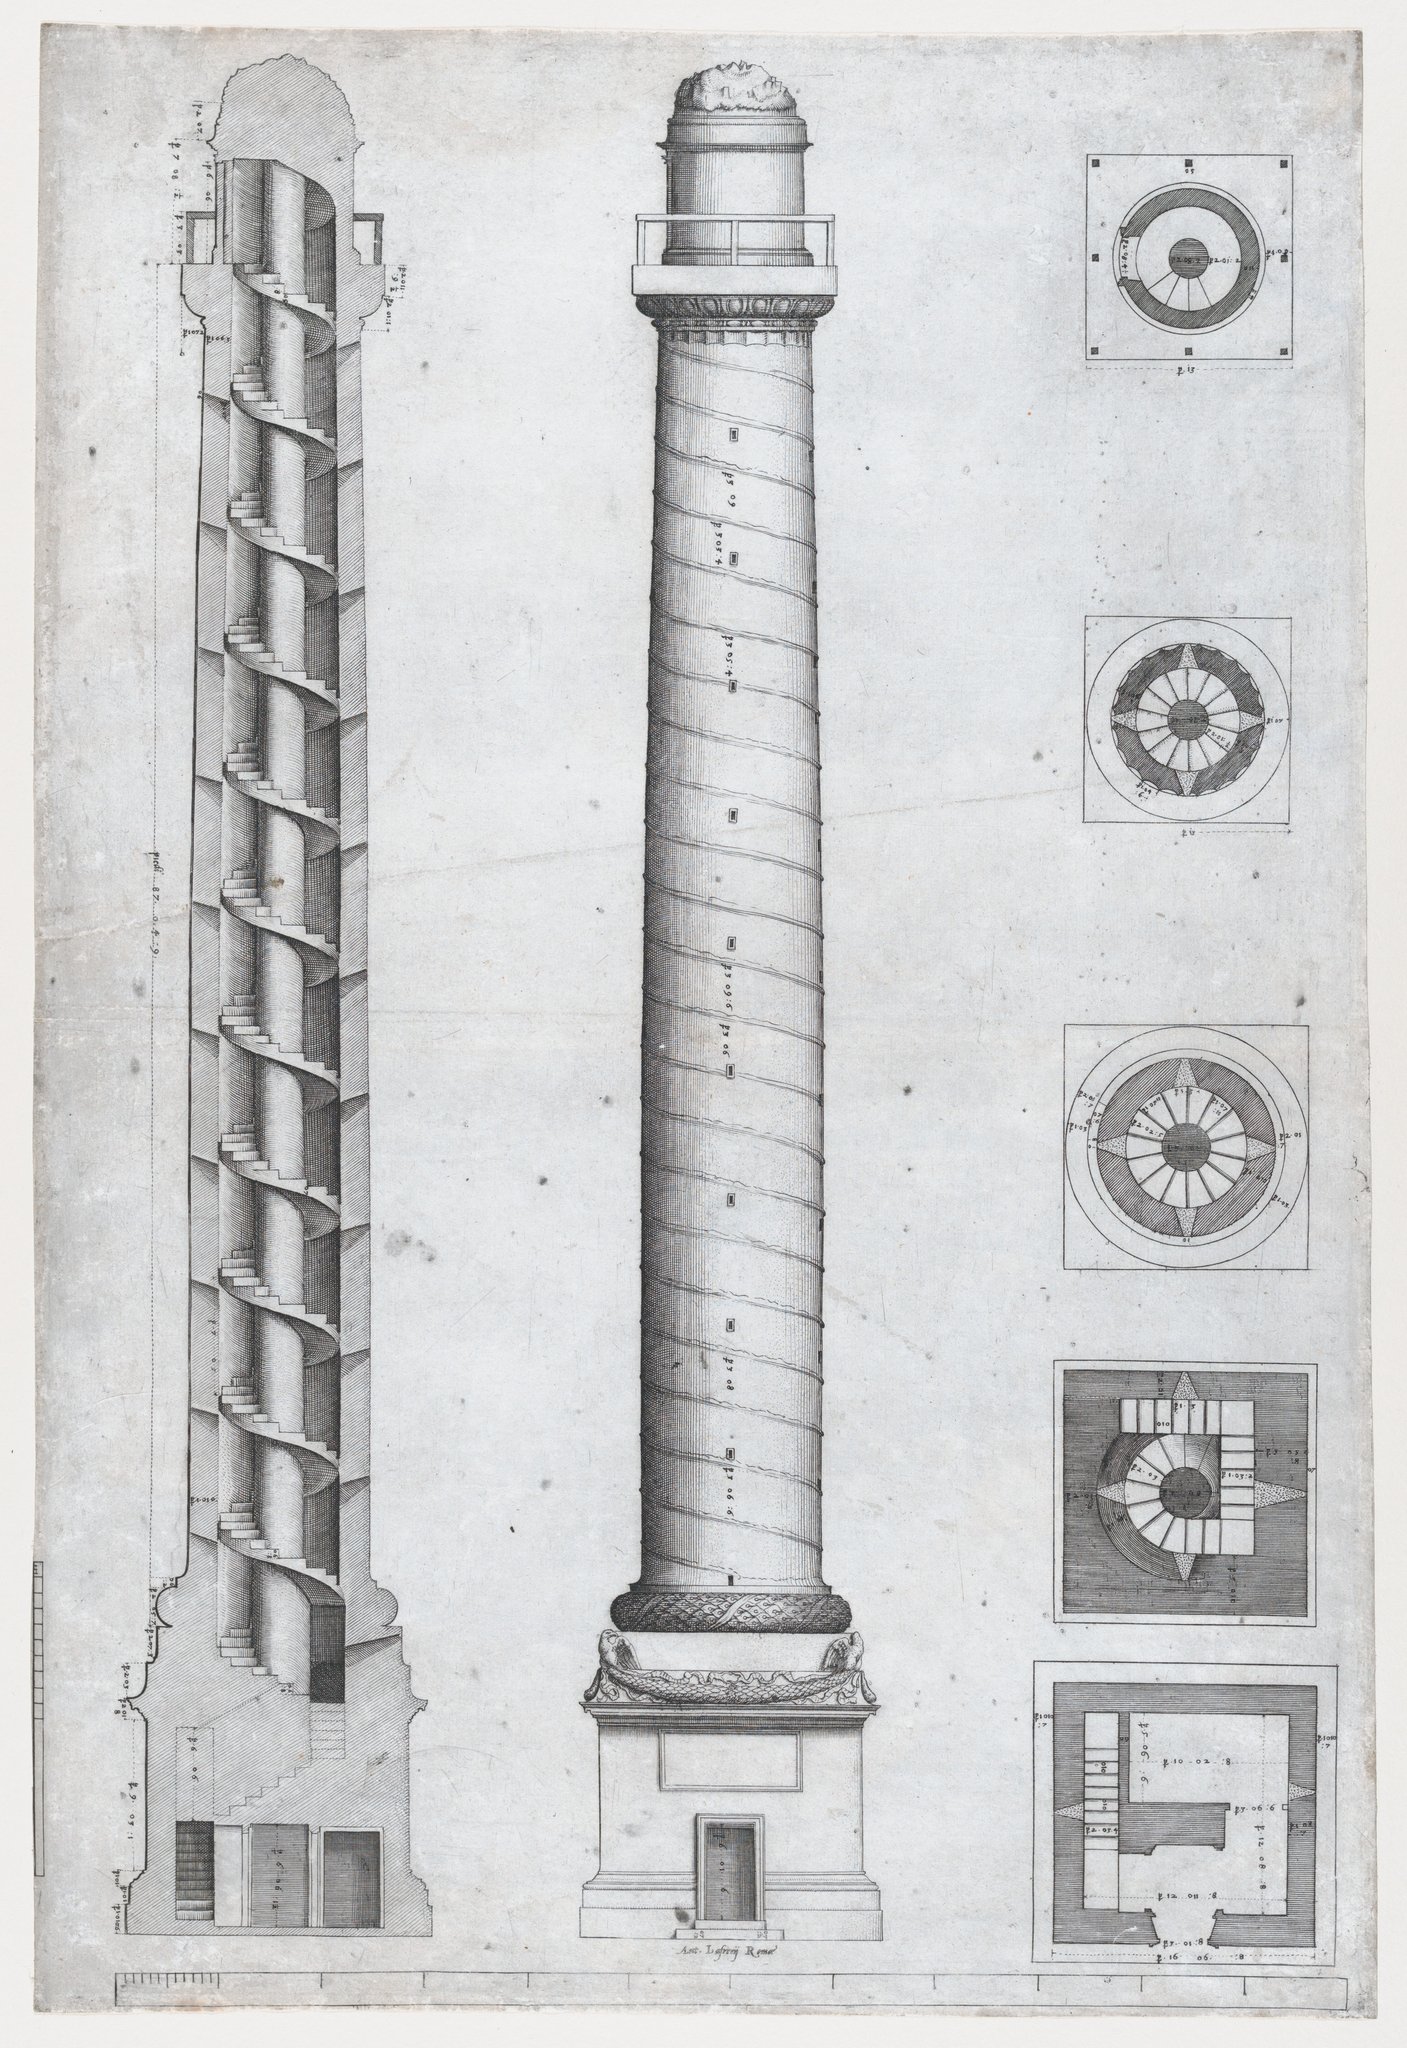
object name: print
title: Trajan's Column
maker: Anonymous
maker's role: artist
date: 1501-1600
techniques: engraving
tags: architecture,columns